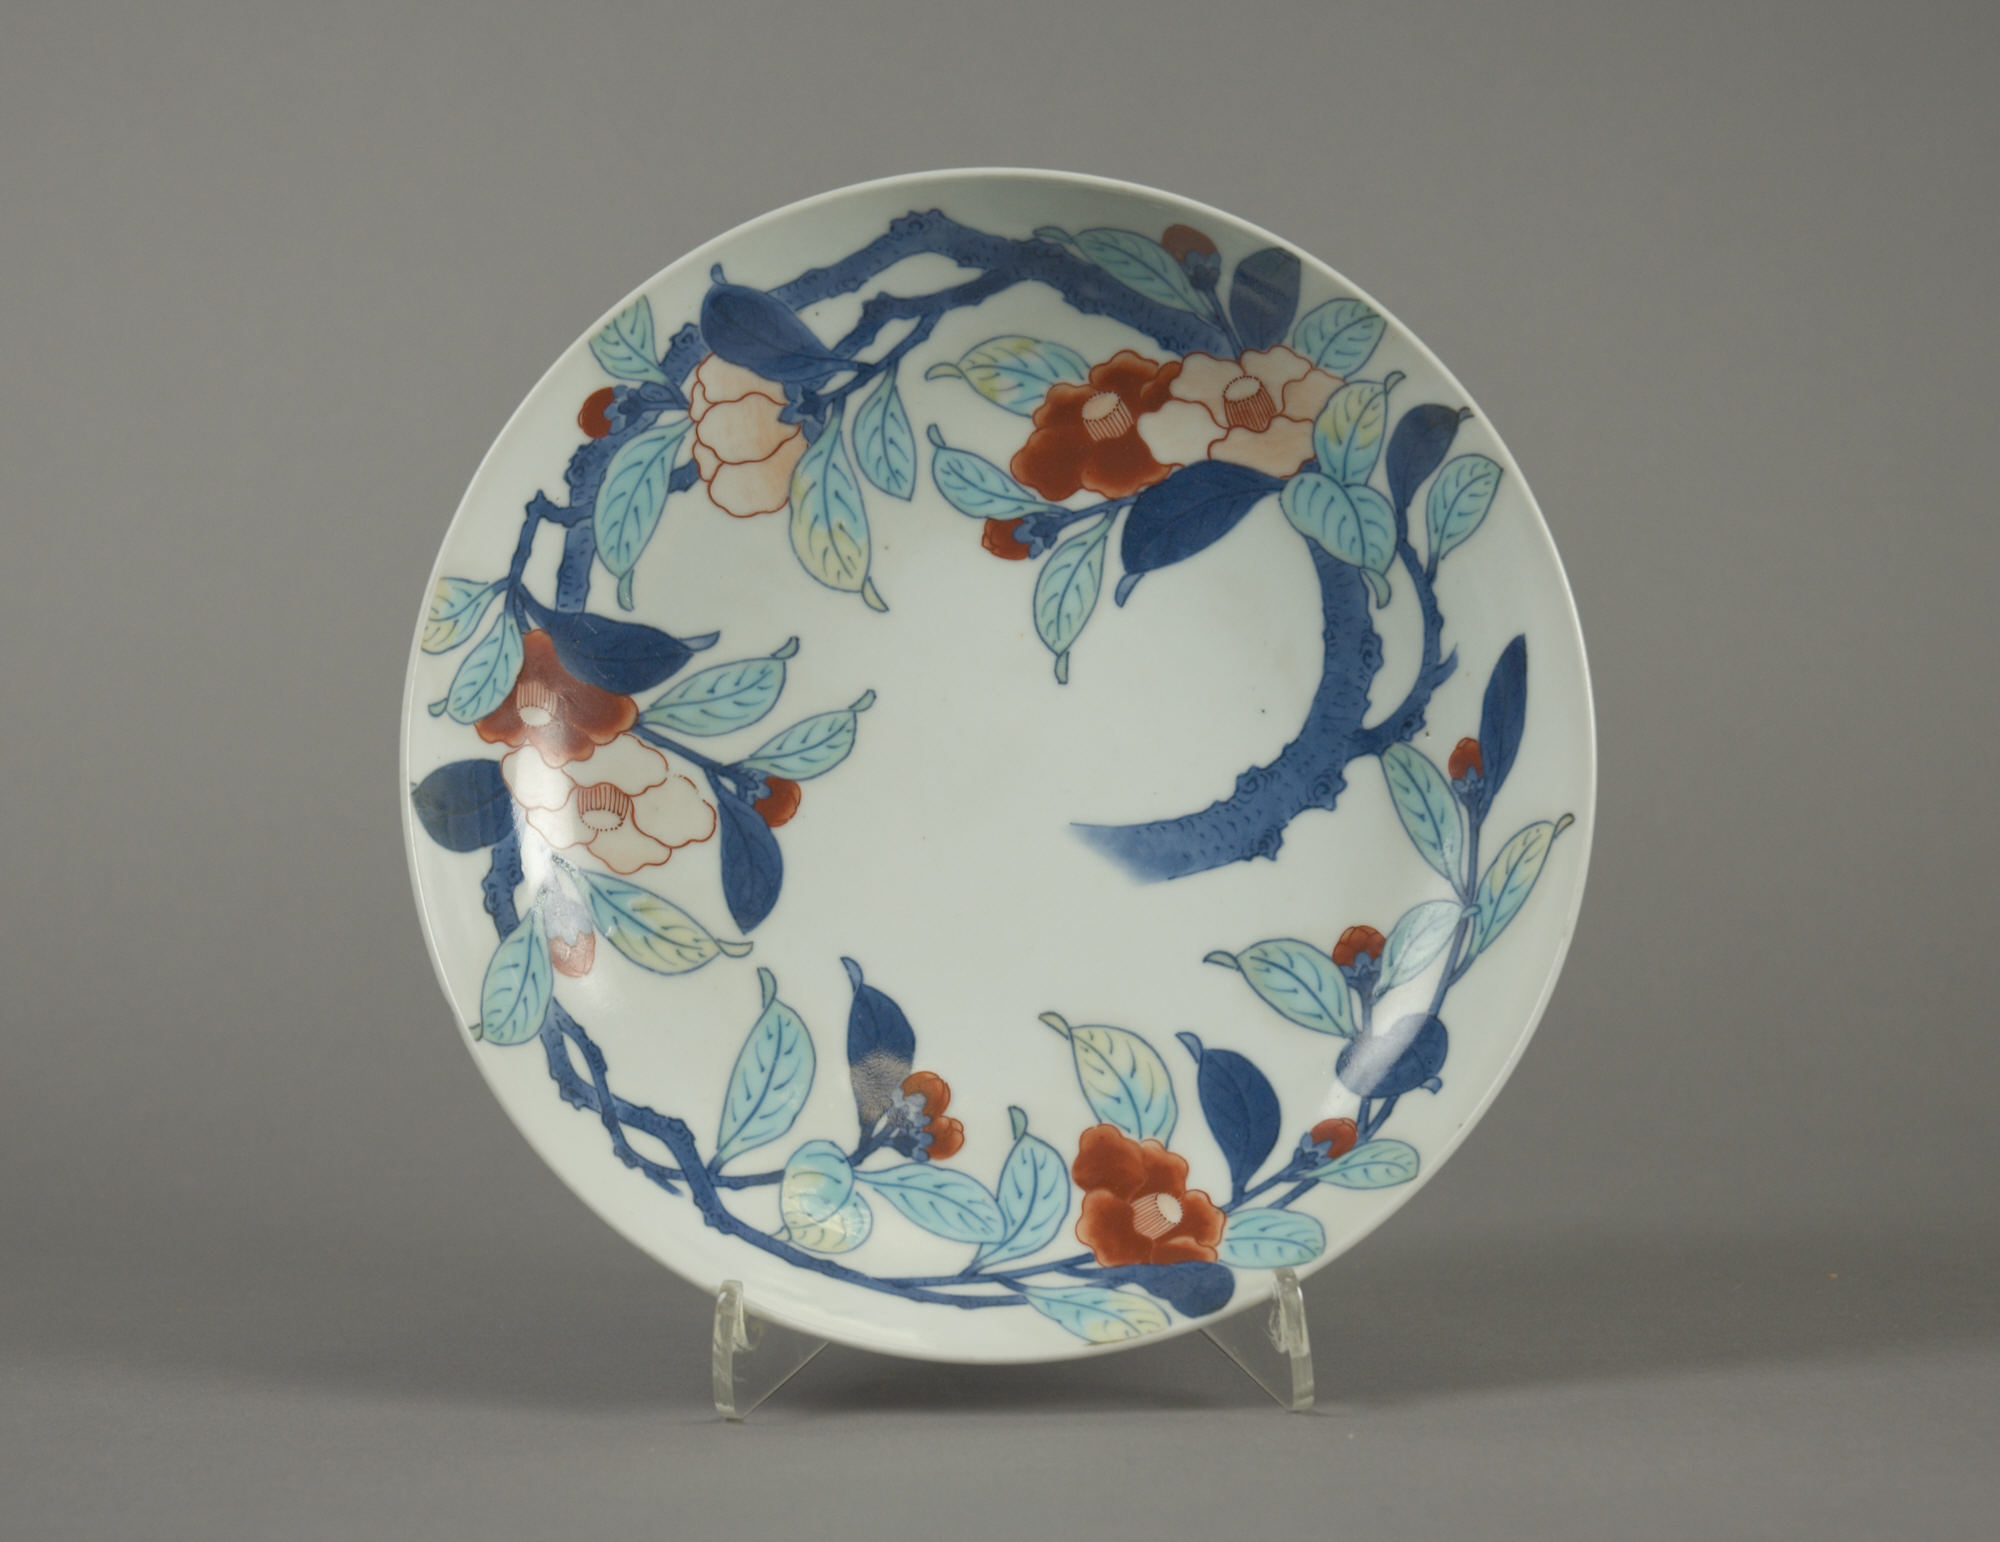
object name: dish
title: Dish with Camellia Design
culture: japanese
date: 1701-1733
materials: enamel, porcelain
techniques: overglaze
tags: flowers,leaves